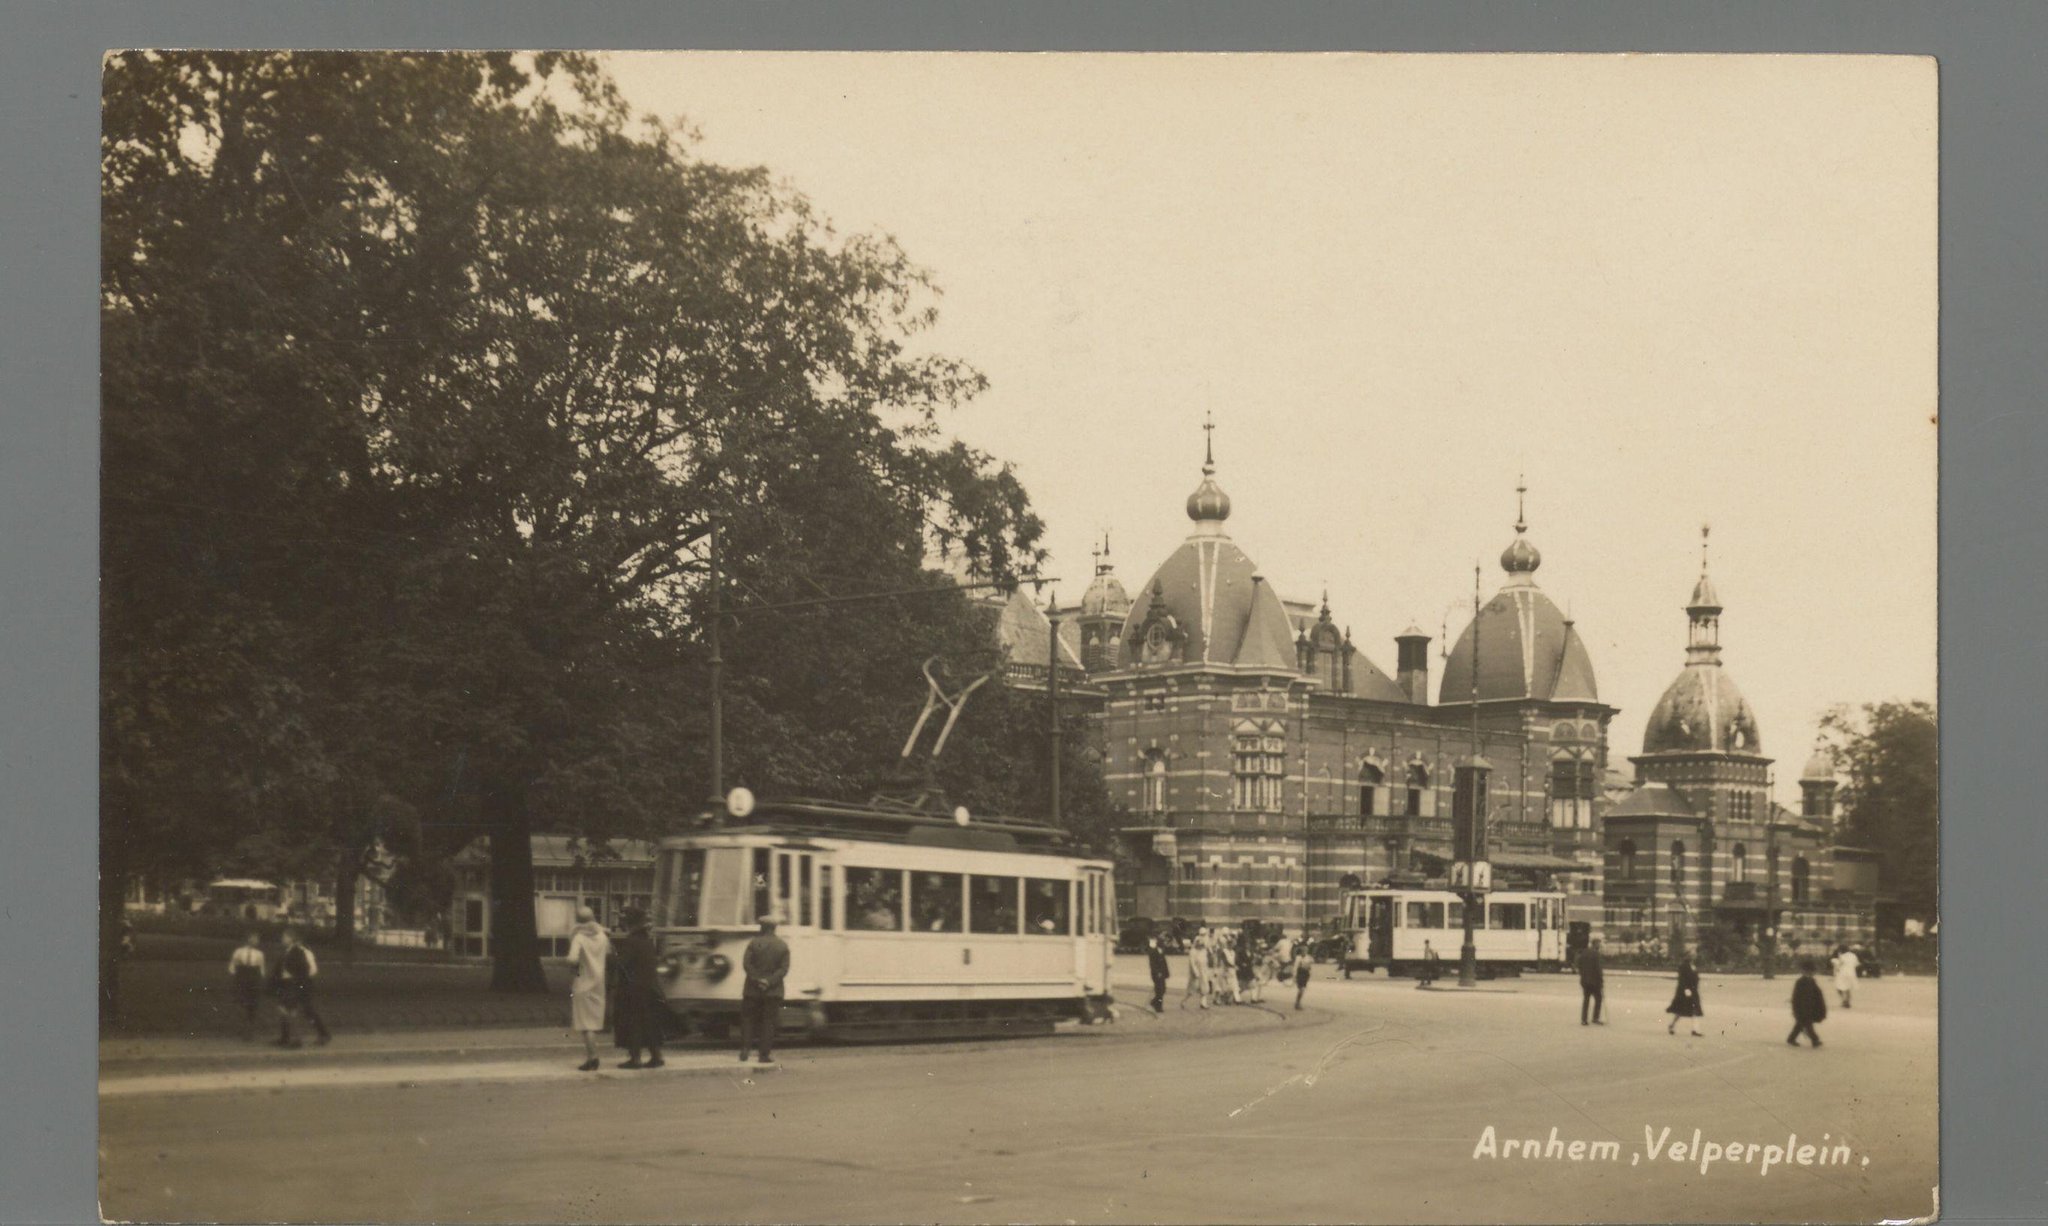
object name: ansichtkaart, prentbriefkaart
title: Arnhem, Velperplein.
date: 1929-1931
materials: photographic support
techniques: photography, writing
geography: arnhem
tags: square, place, circus, etc., arnhem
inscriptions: postage stamp